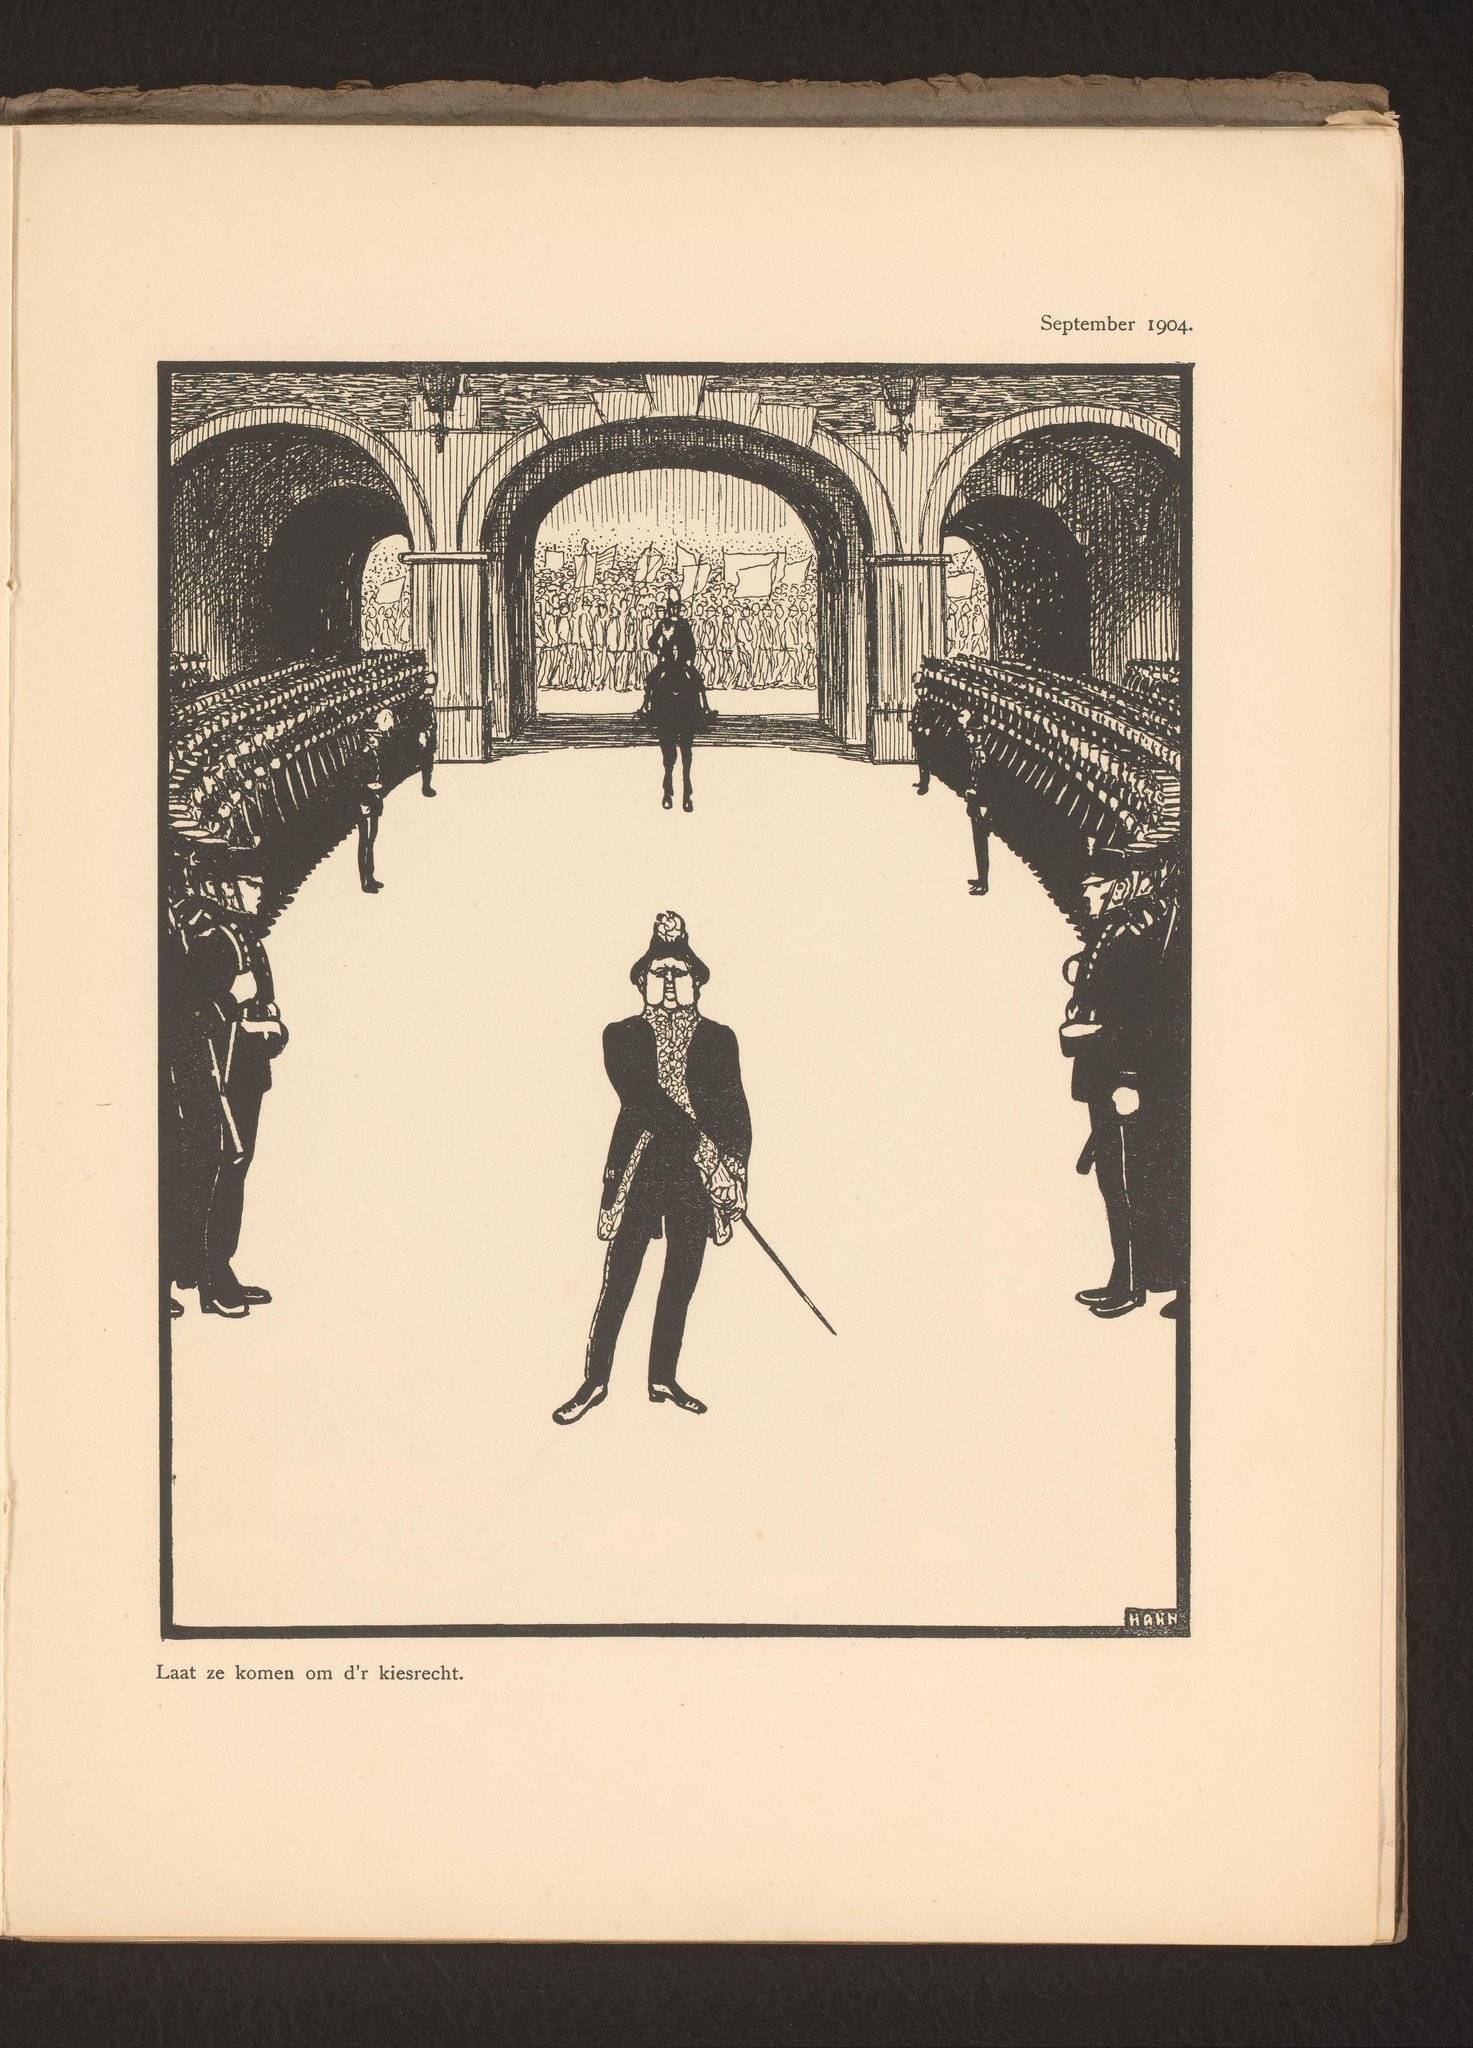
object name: cartoon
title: Laat ze komen om d'r kiesrecht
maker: albert hahn (i)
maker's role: draughtsman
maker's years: 1877-1918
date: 1904-1909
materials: paper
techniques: autotype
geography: netherlands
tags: the hague, abraham kuyper, political demonstration, the right to vote, the compulsory vote, political caricatures and satires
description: Abraham Kuyper trekt zijn degen, op een plein tussen rijen soldaten in het gelid, in de verte een betoging met protestborden, september 1904. Onderdeel van het boek 'Albert Hahn Prenten', heruitgave van een selectie politieke prenten uit de periode 1902-1906.